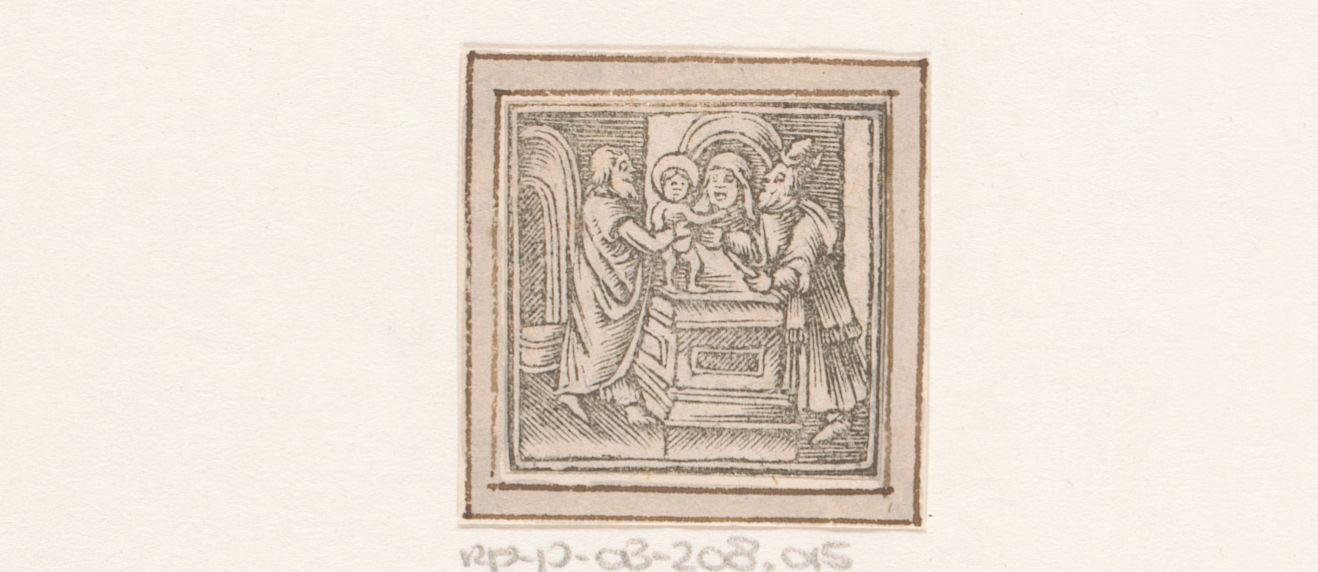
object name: print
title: Besnijdenis van Christus in de tempel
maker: Anonymous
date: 1600-1699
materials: paper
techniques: woodcut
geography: netherlands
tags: circumcision of the christ-child by the priest in the temple (luke 2:21)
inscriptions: collector's mark: Lugt 2228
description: De priester voert de ingreep bij Christus uit terwijl Jozef en Maria het kind vasthouden.